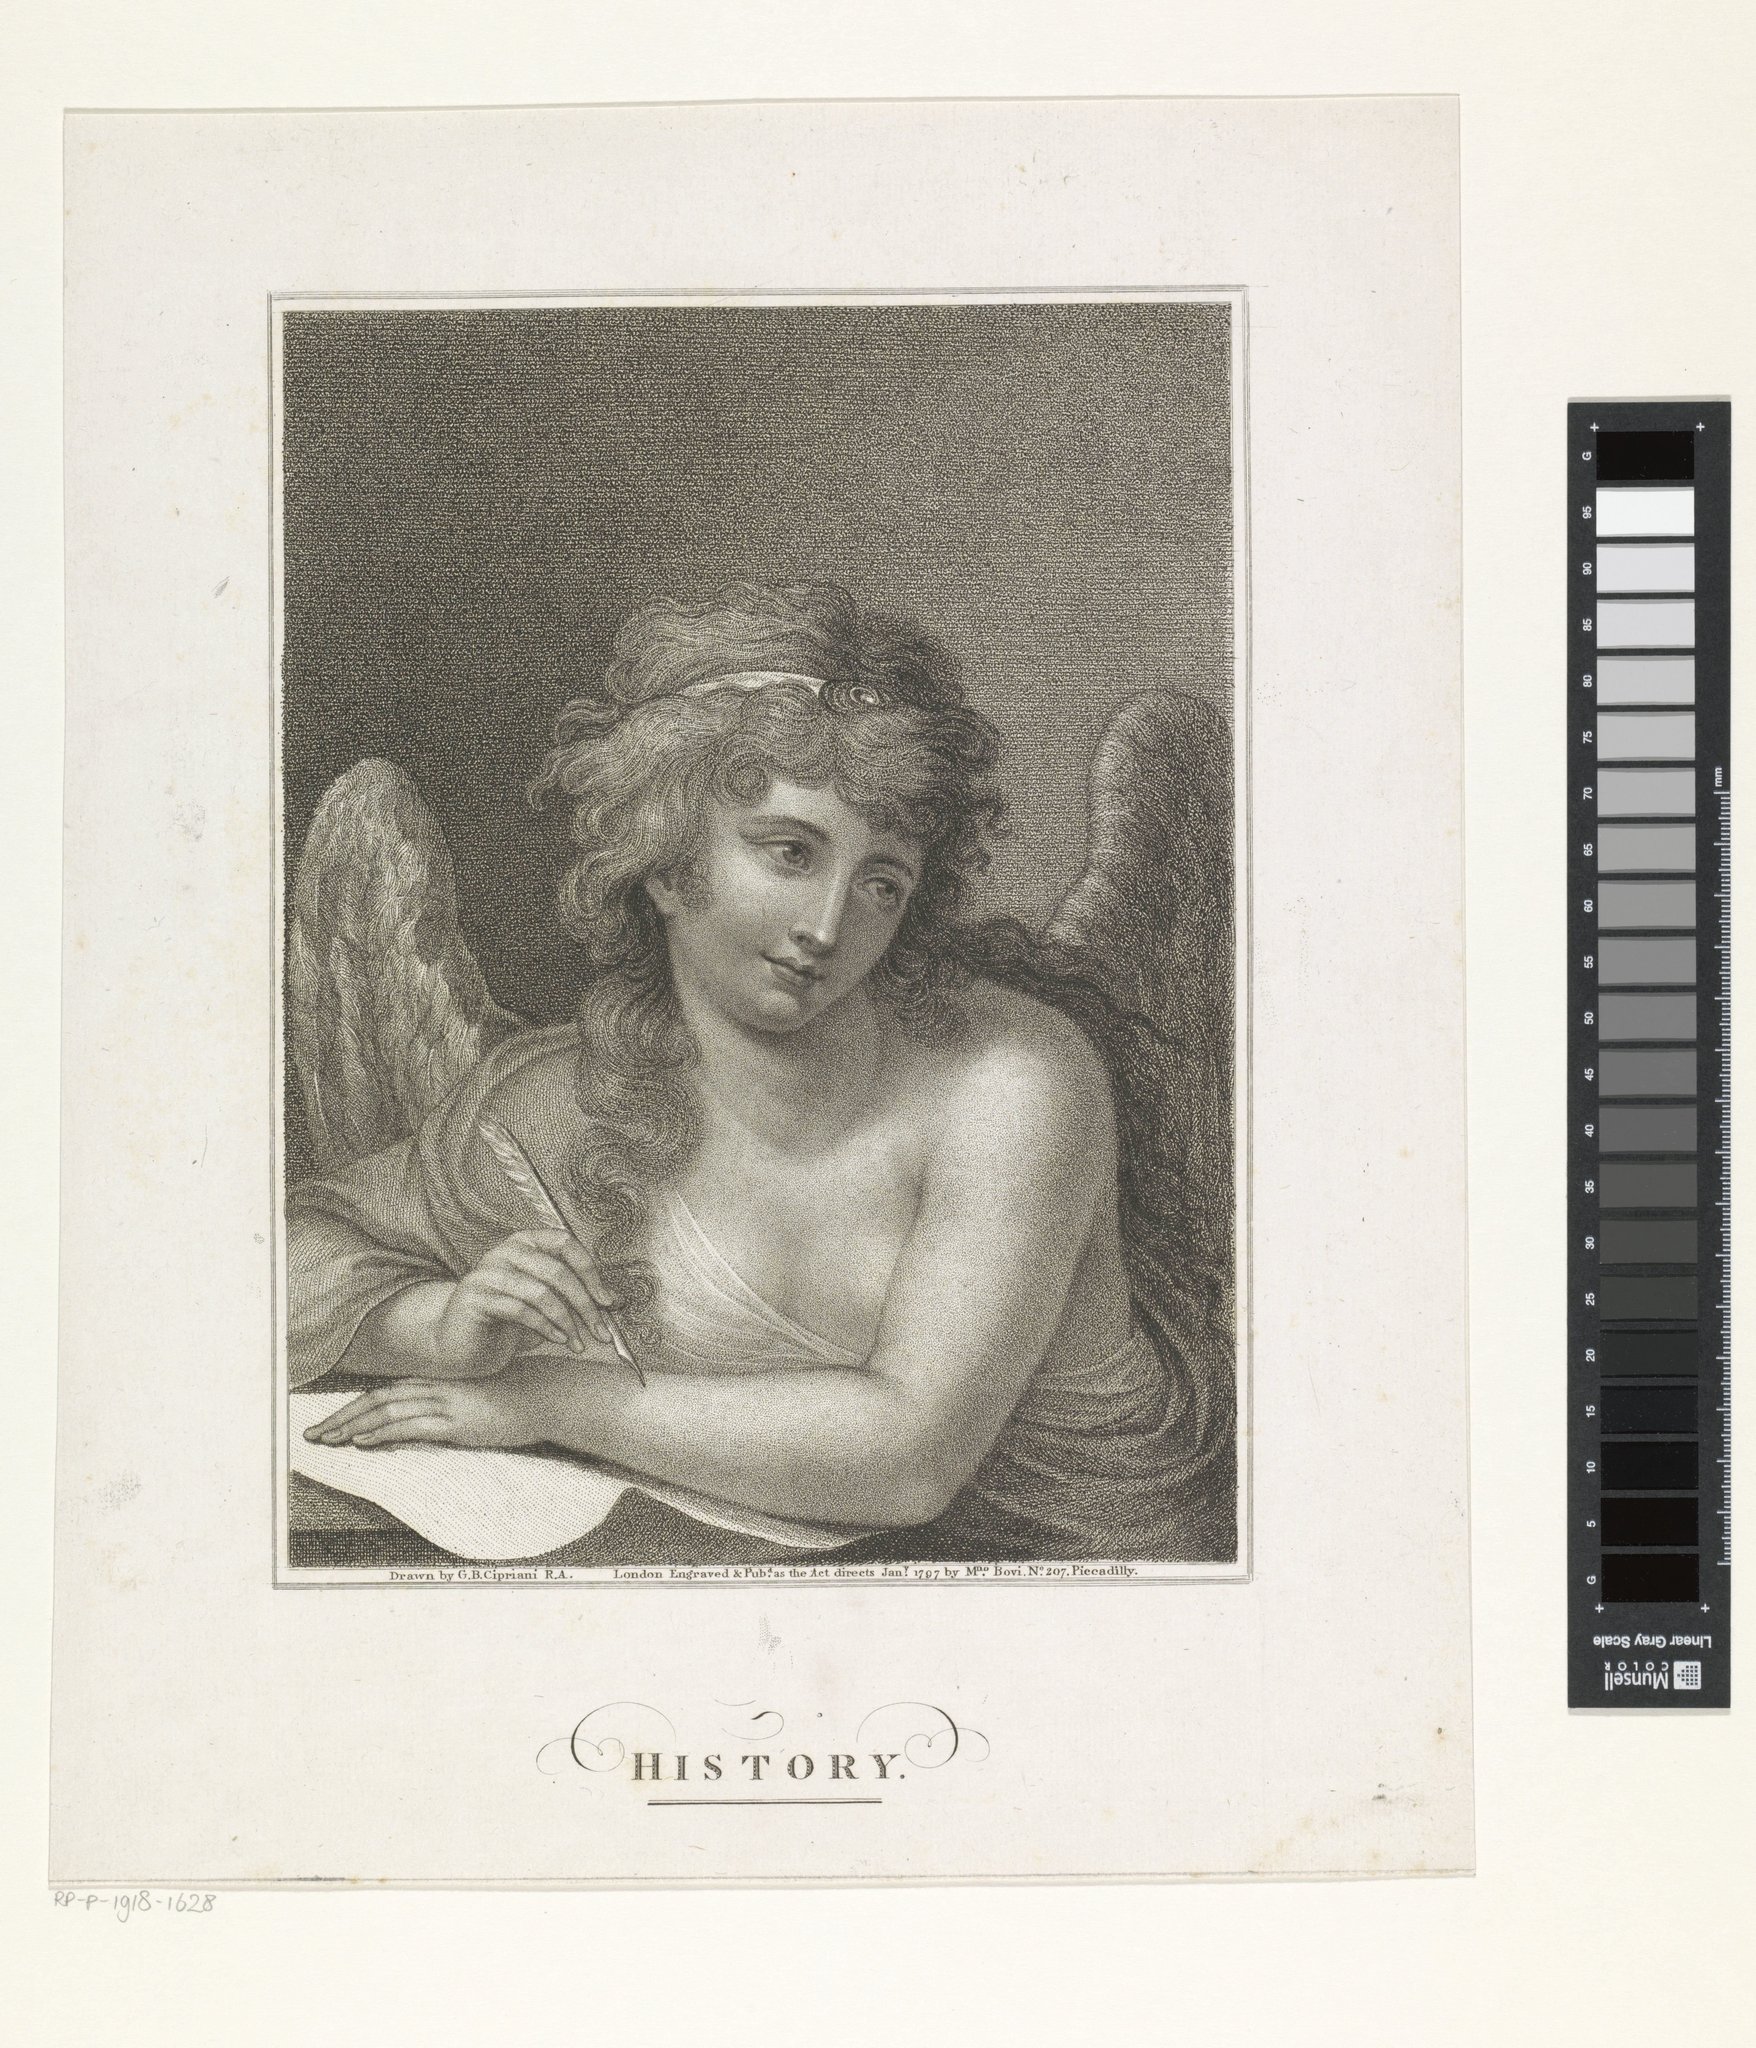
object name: print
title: History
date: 1797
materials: paper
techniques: etching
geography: italy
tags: history, angels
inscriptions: collector's mark: Lugt 2233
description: Een gevleugelde figuur met een schrijfveer, gebogen over een vel papier. Personificatie van de geschiedenis.